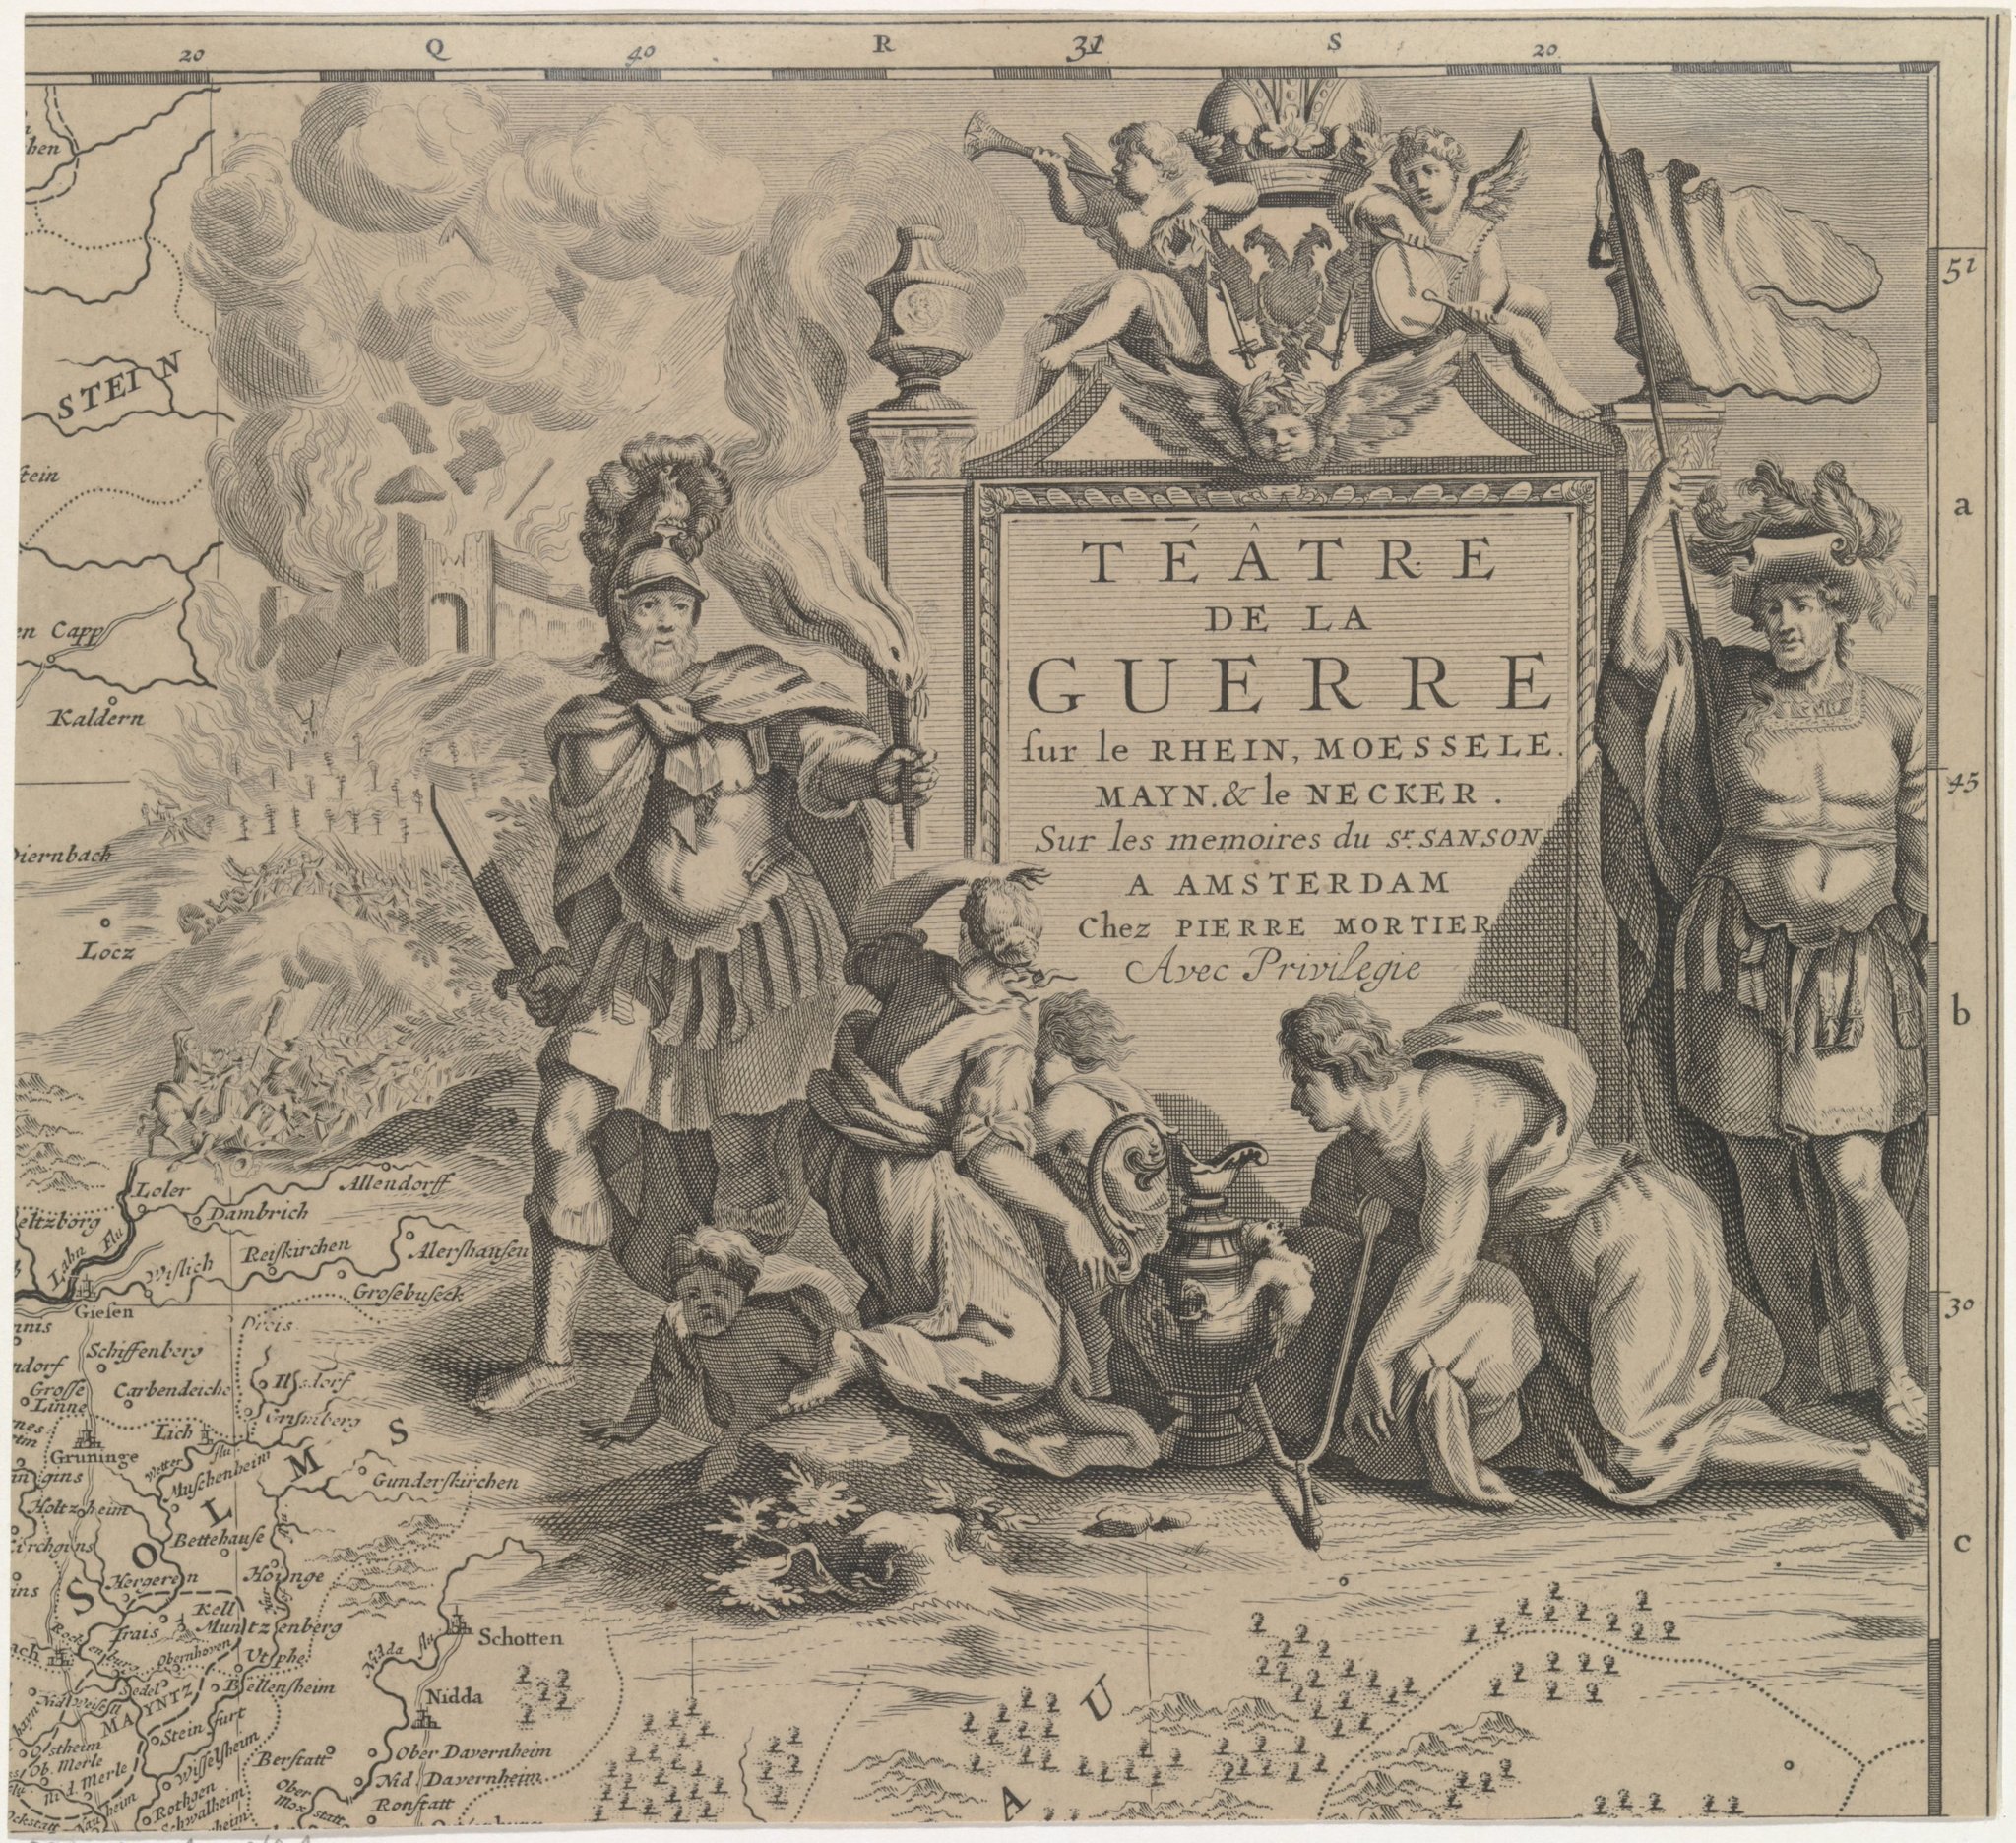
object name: print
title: Kaart van de regio Solms tussen Marburg en Frankfurt am Main in Duitsland (blad rechtsboven)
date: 1689-1712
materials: paper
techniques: engraving, etching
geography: amsterdam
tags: maps of separate countries or regions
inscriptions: collector's mark: Lugt 2228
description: De personificatie van de oorlog met zwaard en fakkel. Een man, vrouw en twee kinderen verschuilen zich voor hem voor een architectonisch plaquette met titel. rechts een man met vaandel. Links een voorstelling van een brandende en expoderende burcht, daarvoor een ruiterleger. Boven de titel een wapen met daarop een tweekoppige adelaar met twee zwaarden, geflankeerd door twee putti en met kroon bekroond. Links en onder de kaart van de regio Solms tussen Marburg en Frankfurt am Main.